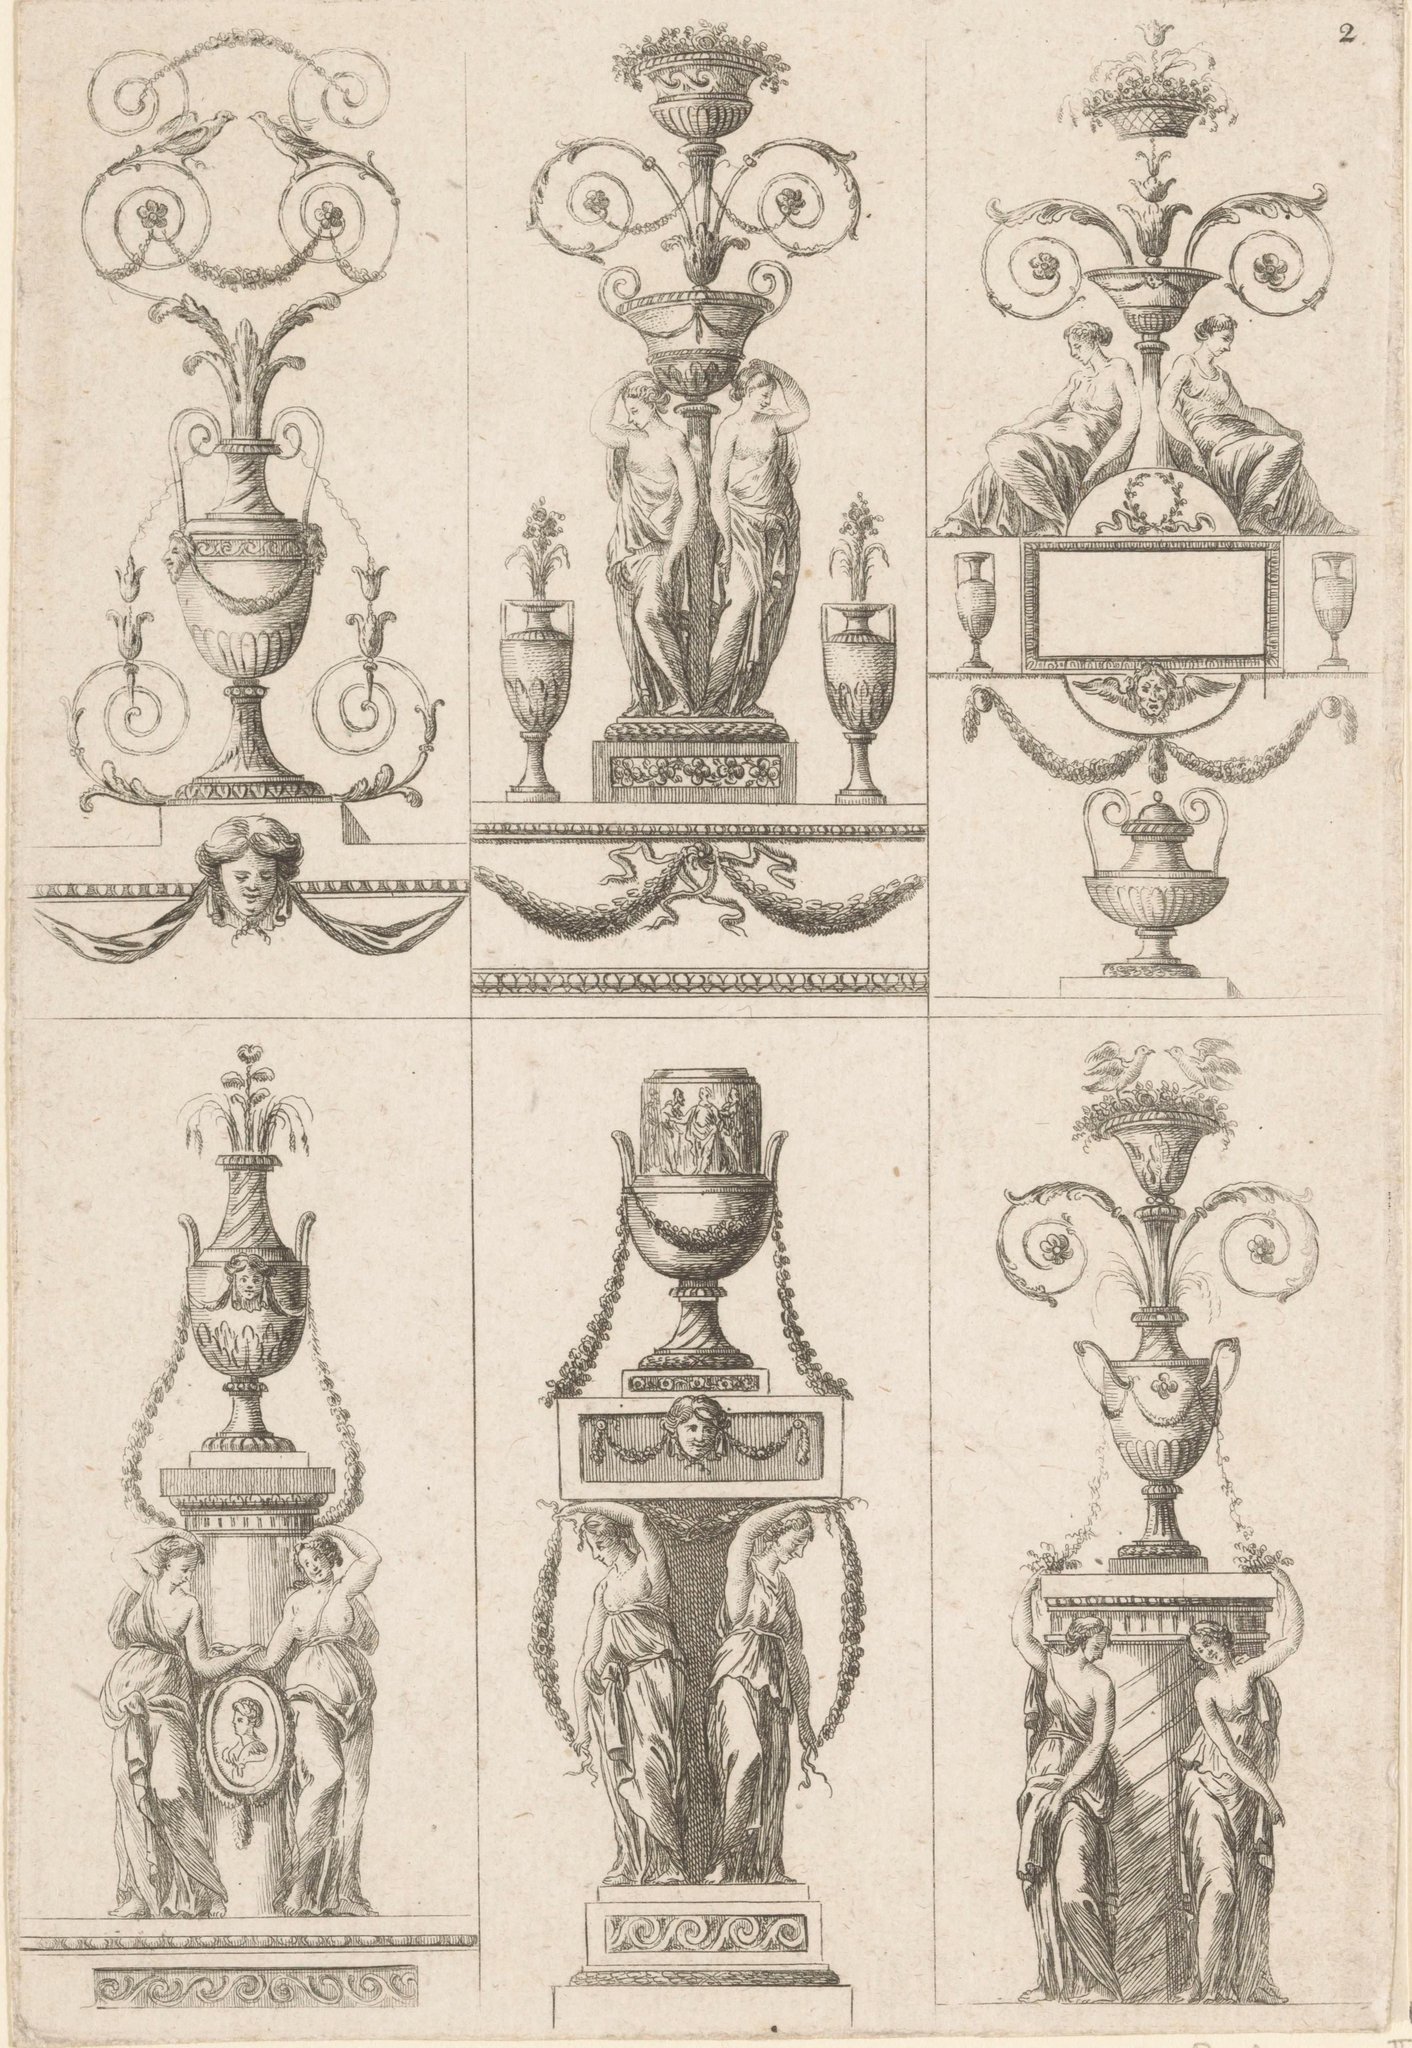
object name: ornament print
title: Zes scènes met arabesken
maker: kollmann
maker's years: 1700-1799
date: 1746-1800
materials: paper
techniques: etching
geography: paris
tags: ornament ~ arabesque, vase ~ ornament, postures of the human figure - aa - female human figure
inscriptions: collector's mark: Lugt 2228, collector's mark: Lugt 2760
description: Zes scènes met arabesken, staande en zittende vrouwen en vazen.